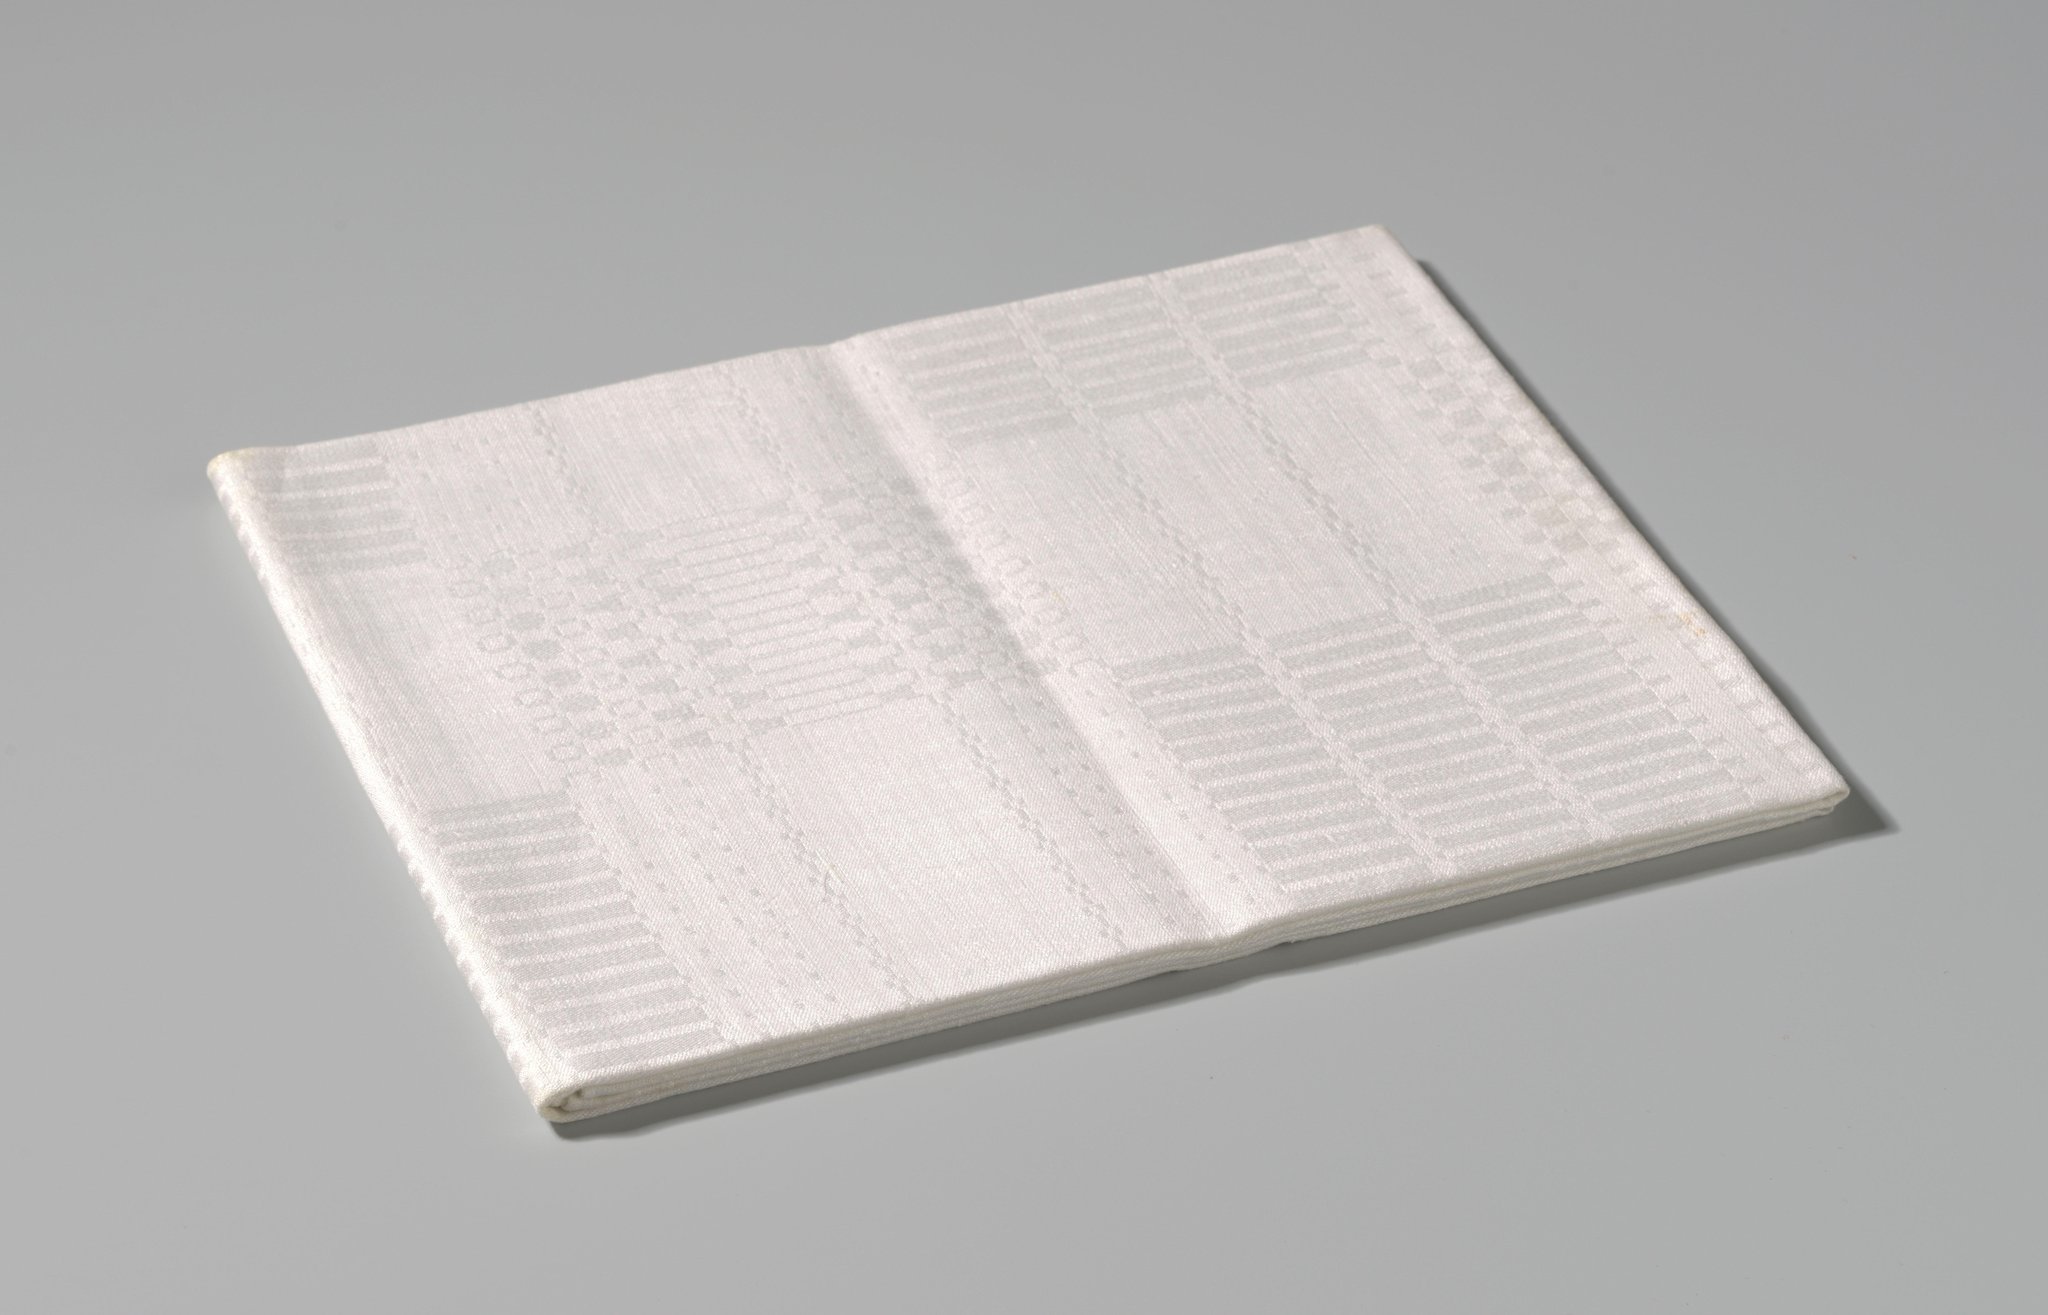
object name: napkin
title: Servet van linnen met pellenpatroon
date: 1785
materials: linen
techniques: peeled fabric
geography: northern netherlands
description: wit linnen servet met pellen patroon, merk SW 34 en 1785